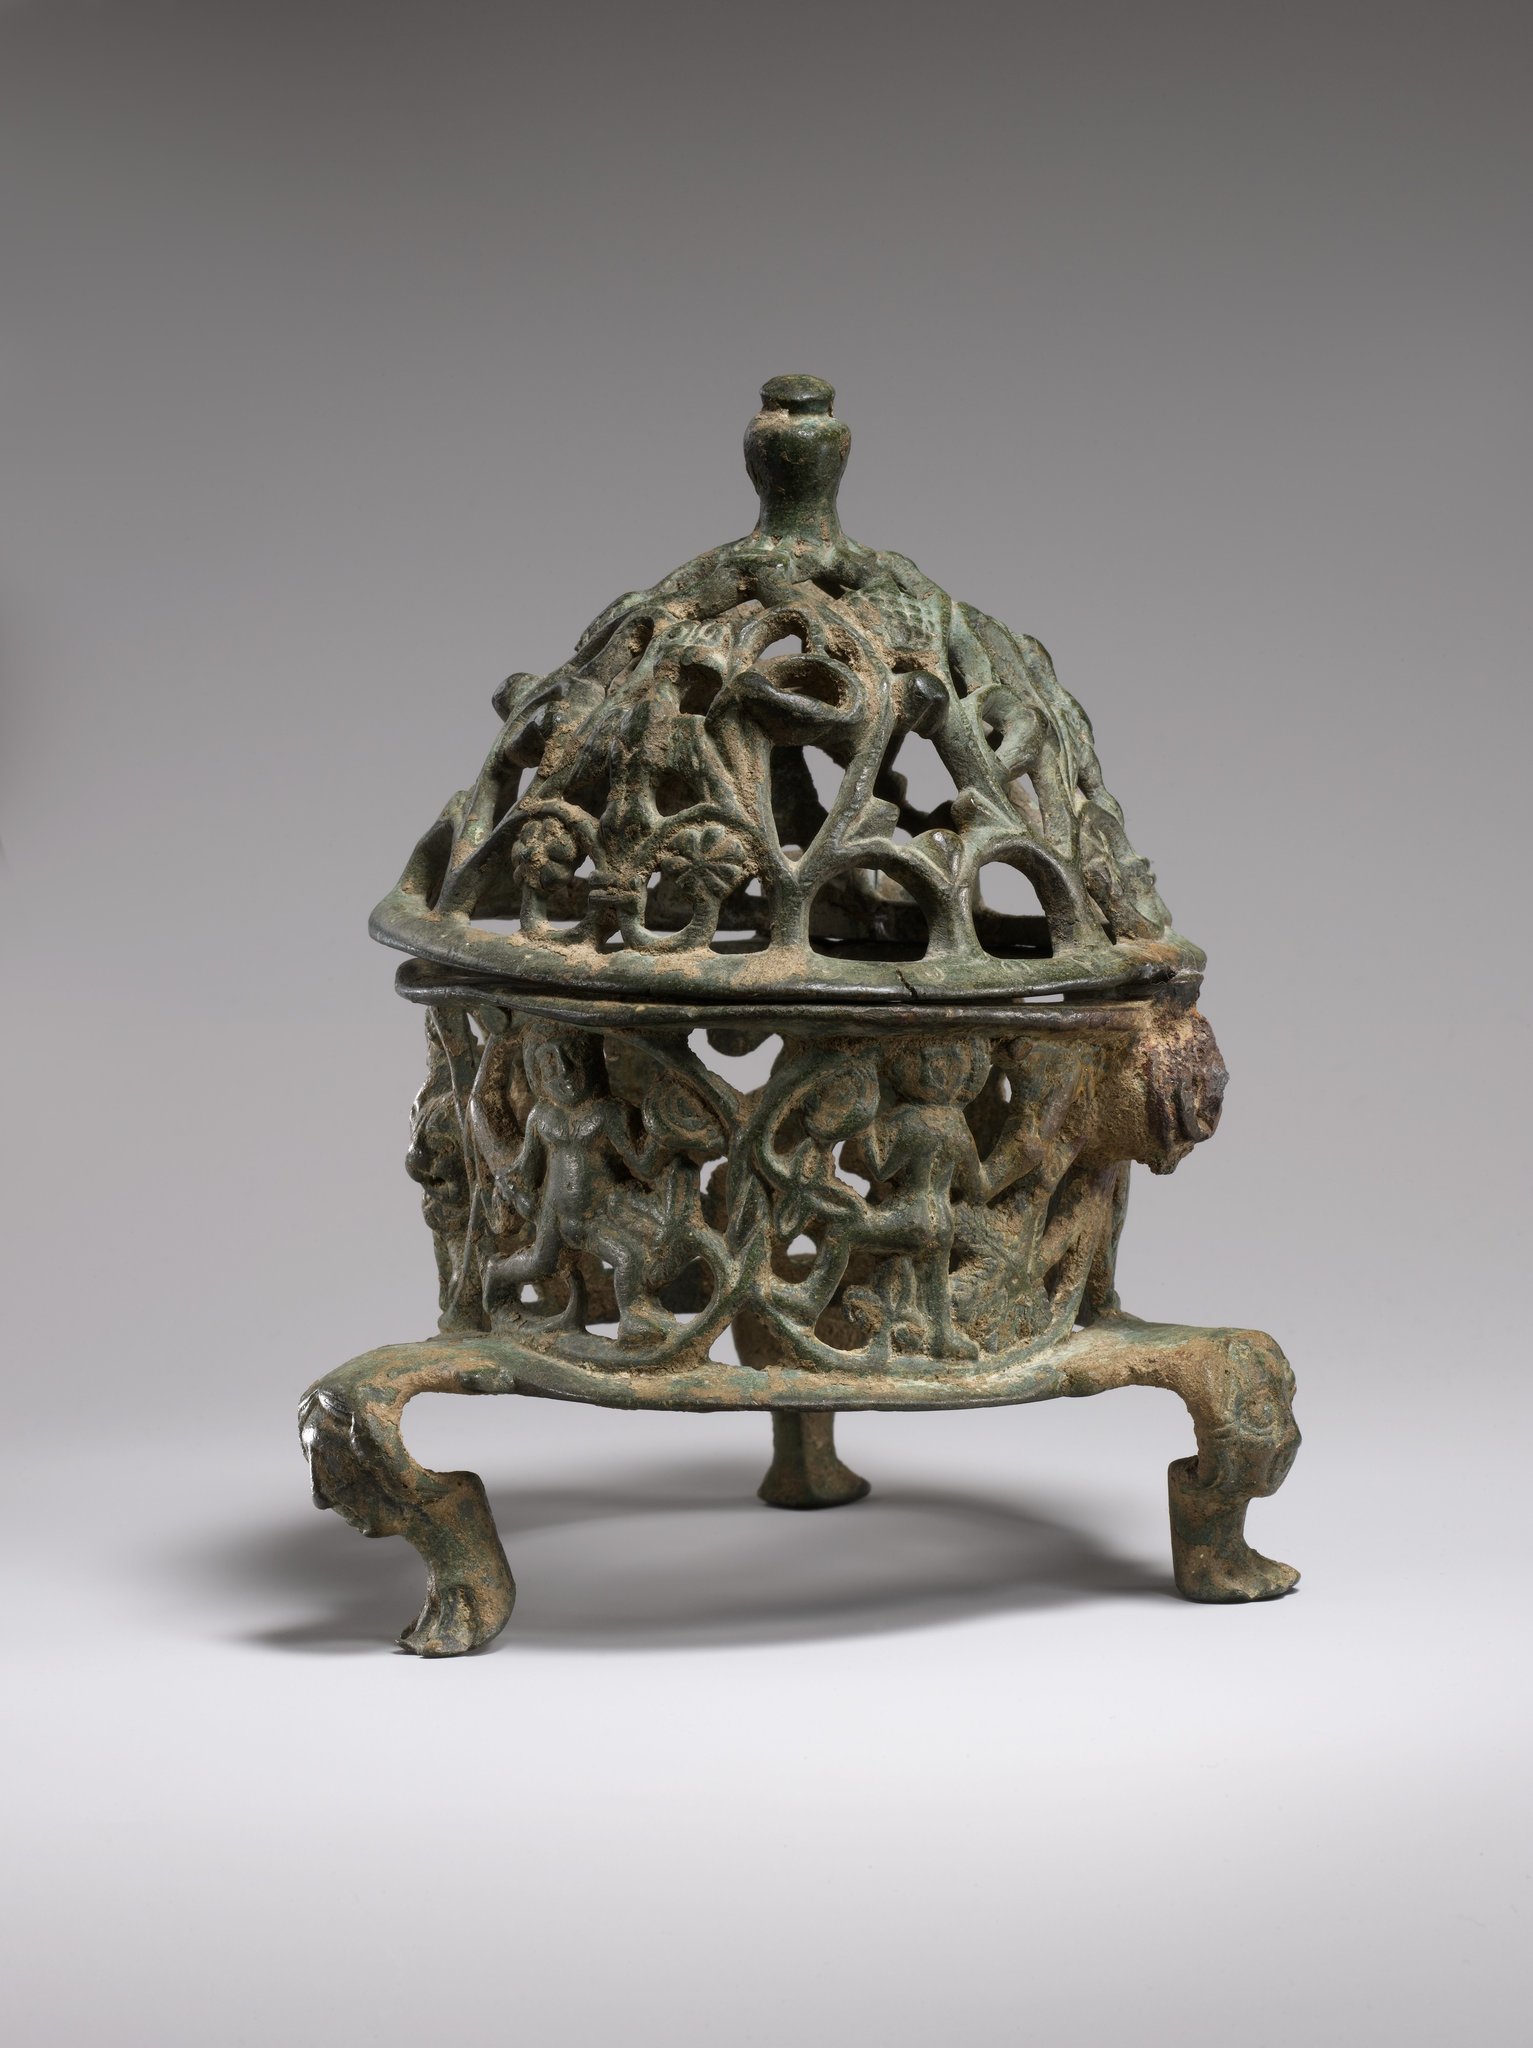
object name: censer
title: Censer Frame with Inhabited Vine Scroll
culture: byzantine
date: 501-600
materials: copper alloy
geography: syria